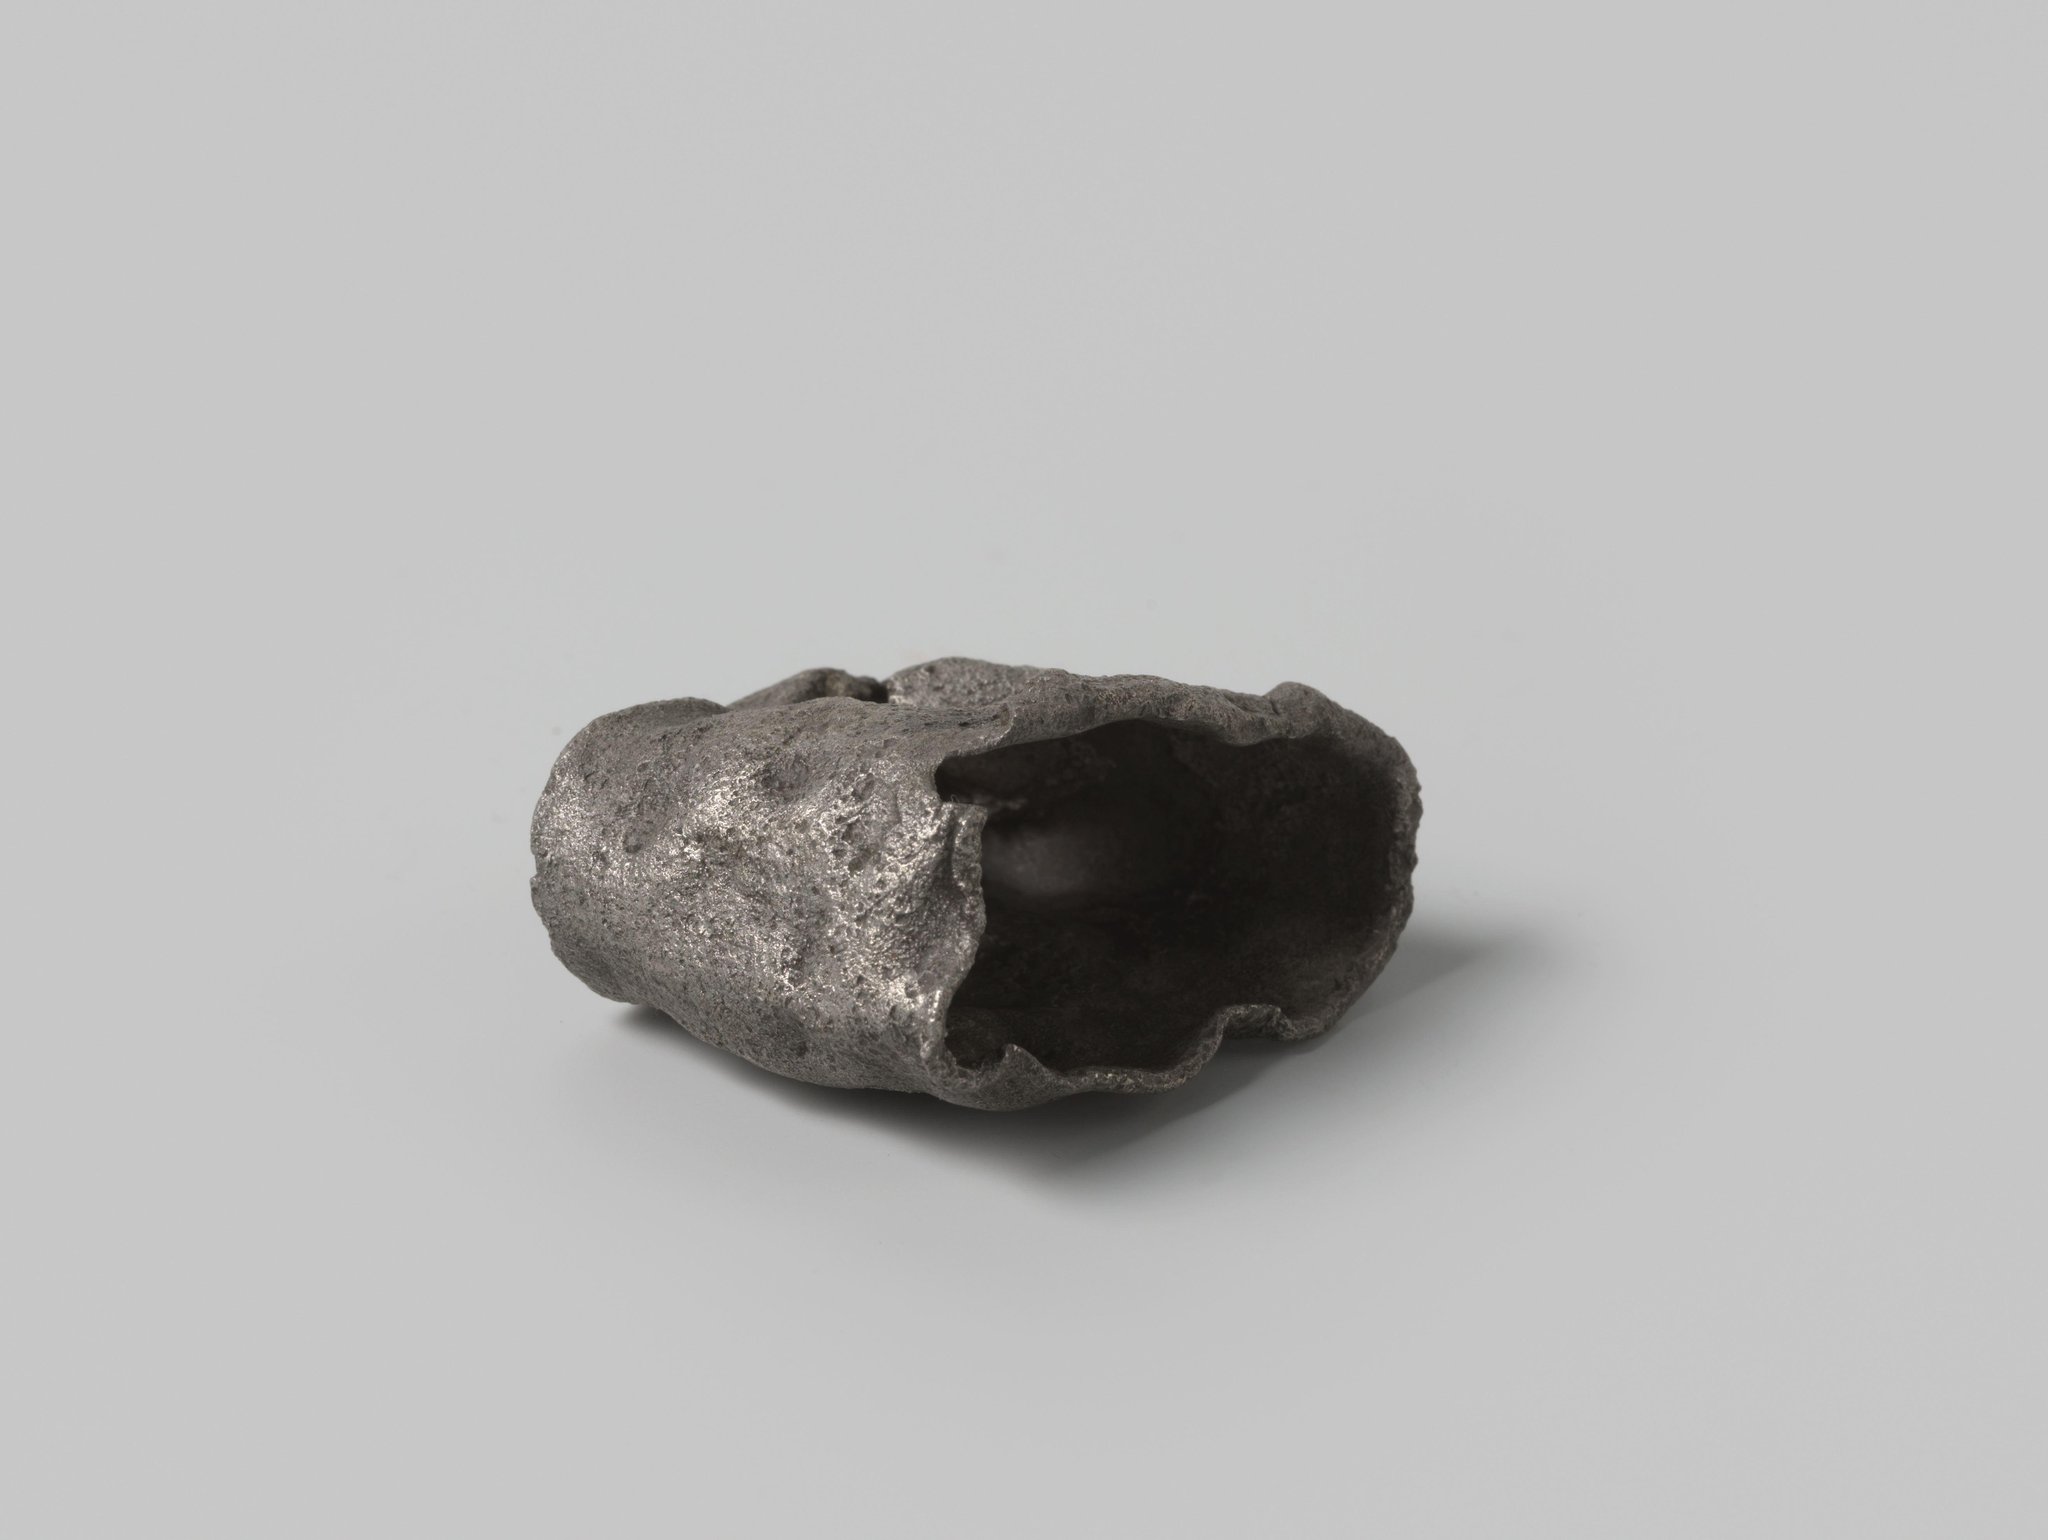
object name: cup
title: Beker uit het wrak van de Oost-Indiëvaarder Hollandia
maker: Anonymous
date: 1700-1743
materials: tin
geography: netherlands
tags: verenigde oostindische compagnie, hollandia (schip), annet